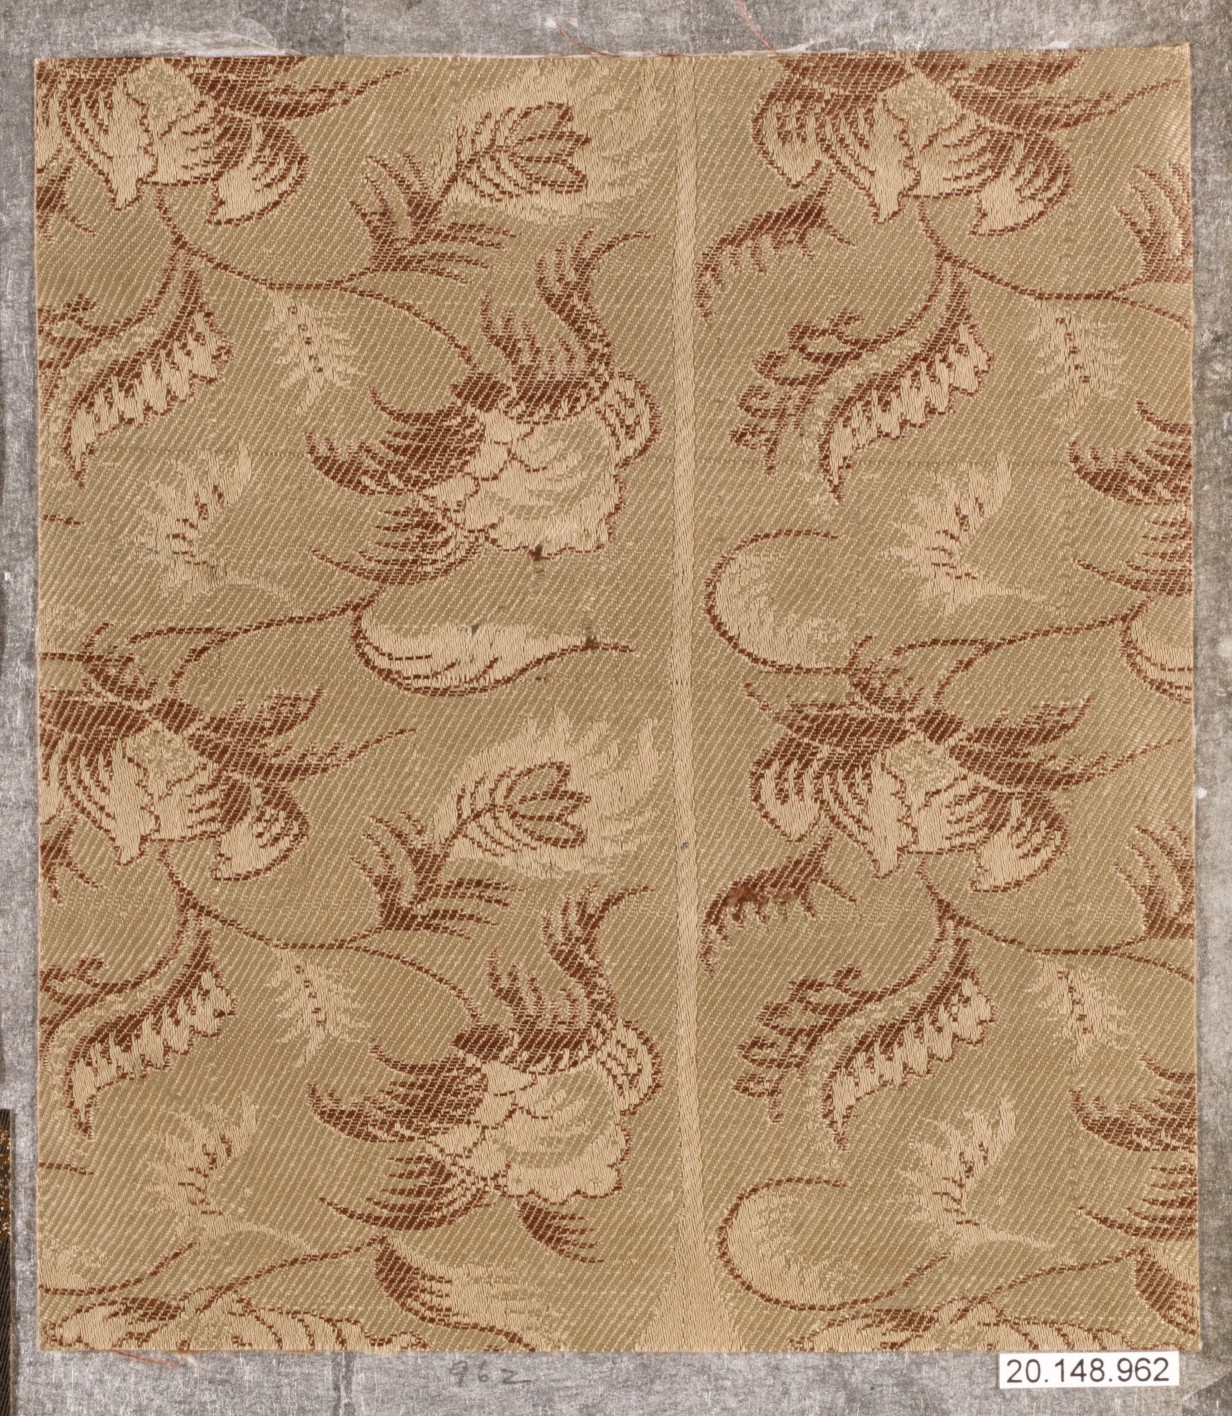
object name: piece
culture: japanese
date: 1701-1800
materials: silk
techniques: compound weave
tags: flowers,leaves